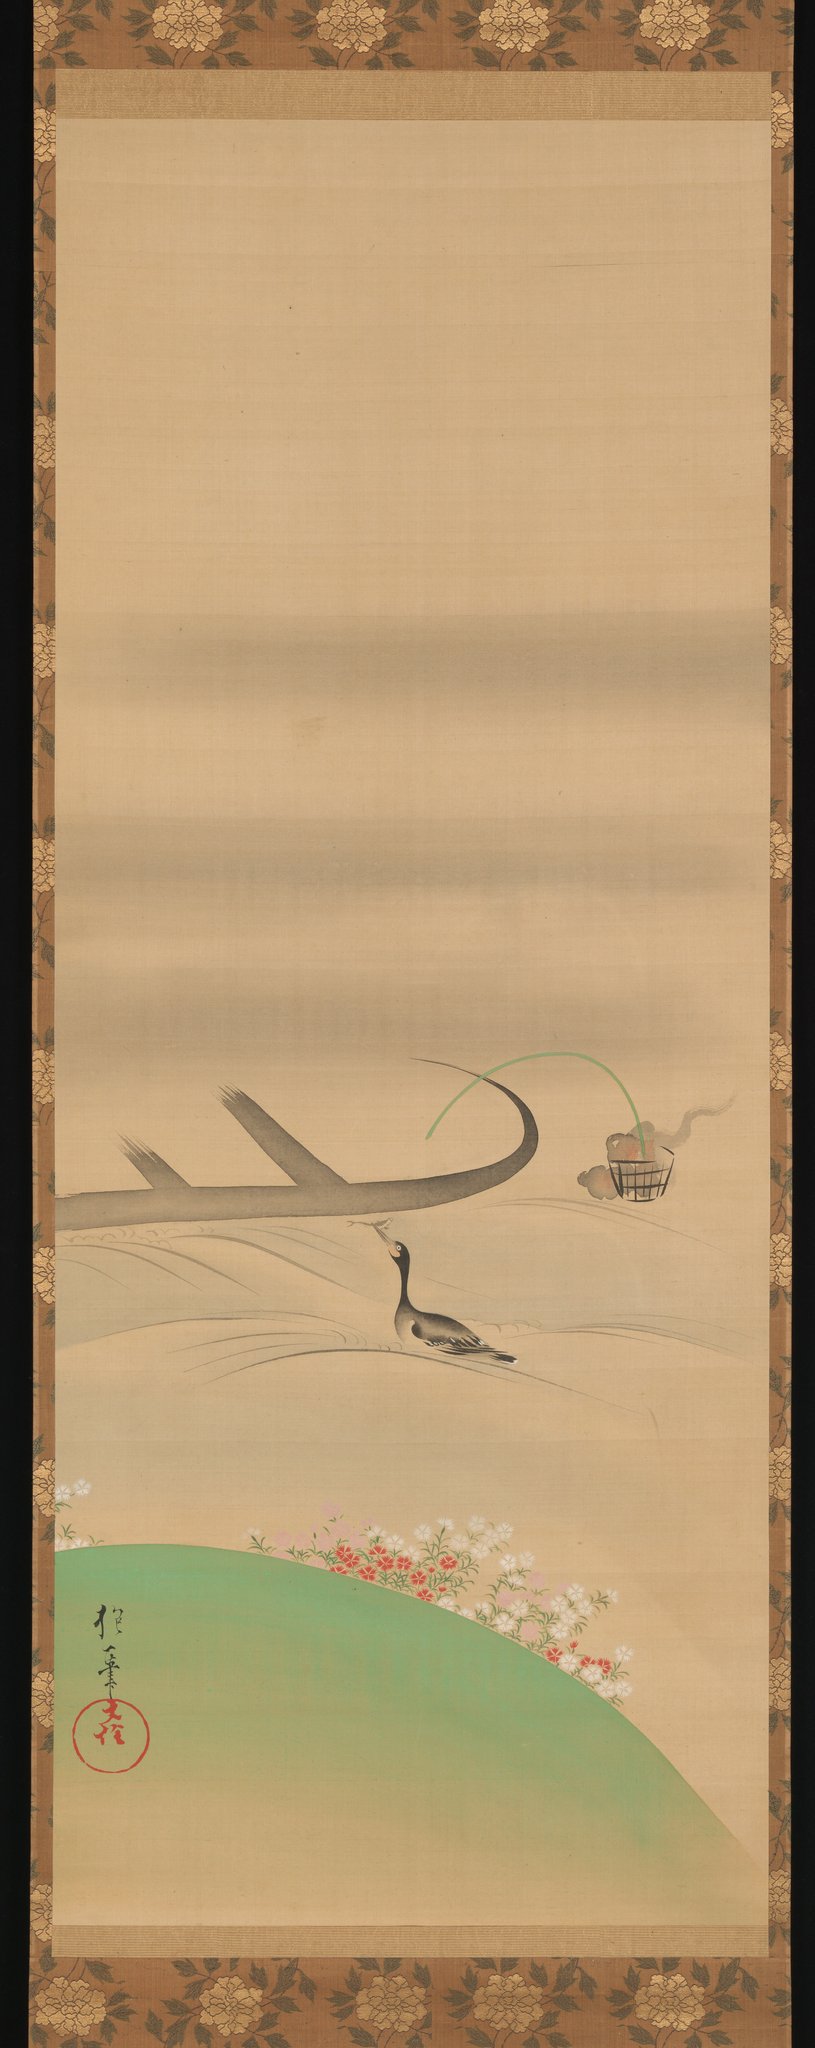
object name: hanging scroll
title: Cormorant Fishing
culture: japanese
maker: sakai hōitsu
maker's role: artist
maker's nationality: japanese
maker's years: 1761-1828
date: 1761-1828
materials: ink, silk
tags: birds,fishing,flowers